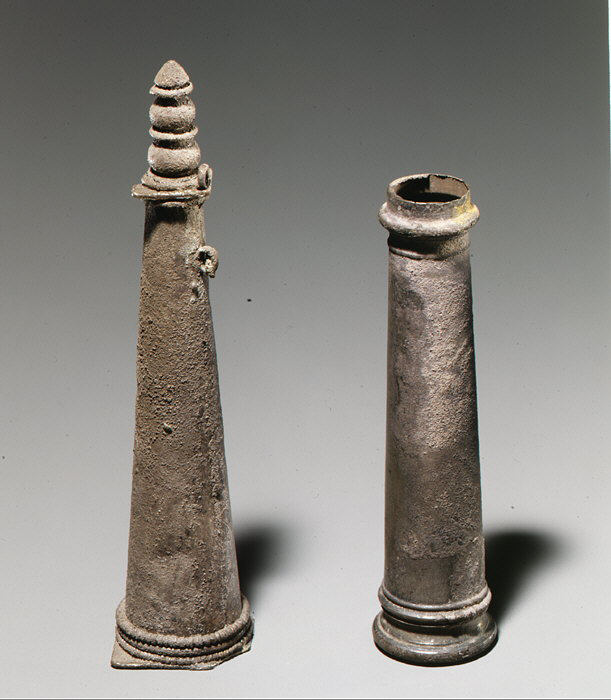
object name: cosmetic vessel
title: Silver cosmetic vessel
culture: east greek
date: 600-501 BCE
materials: silver